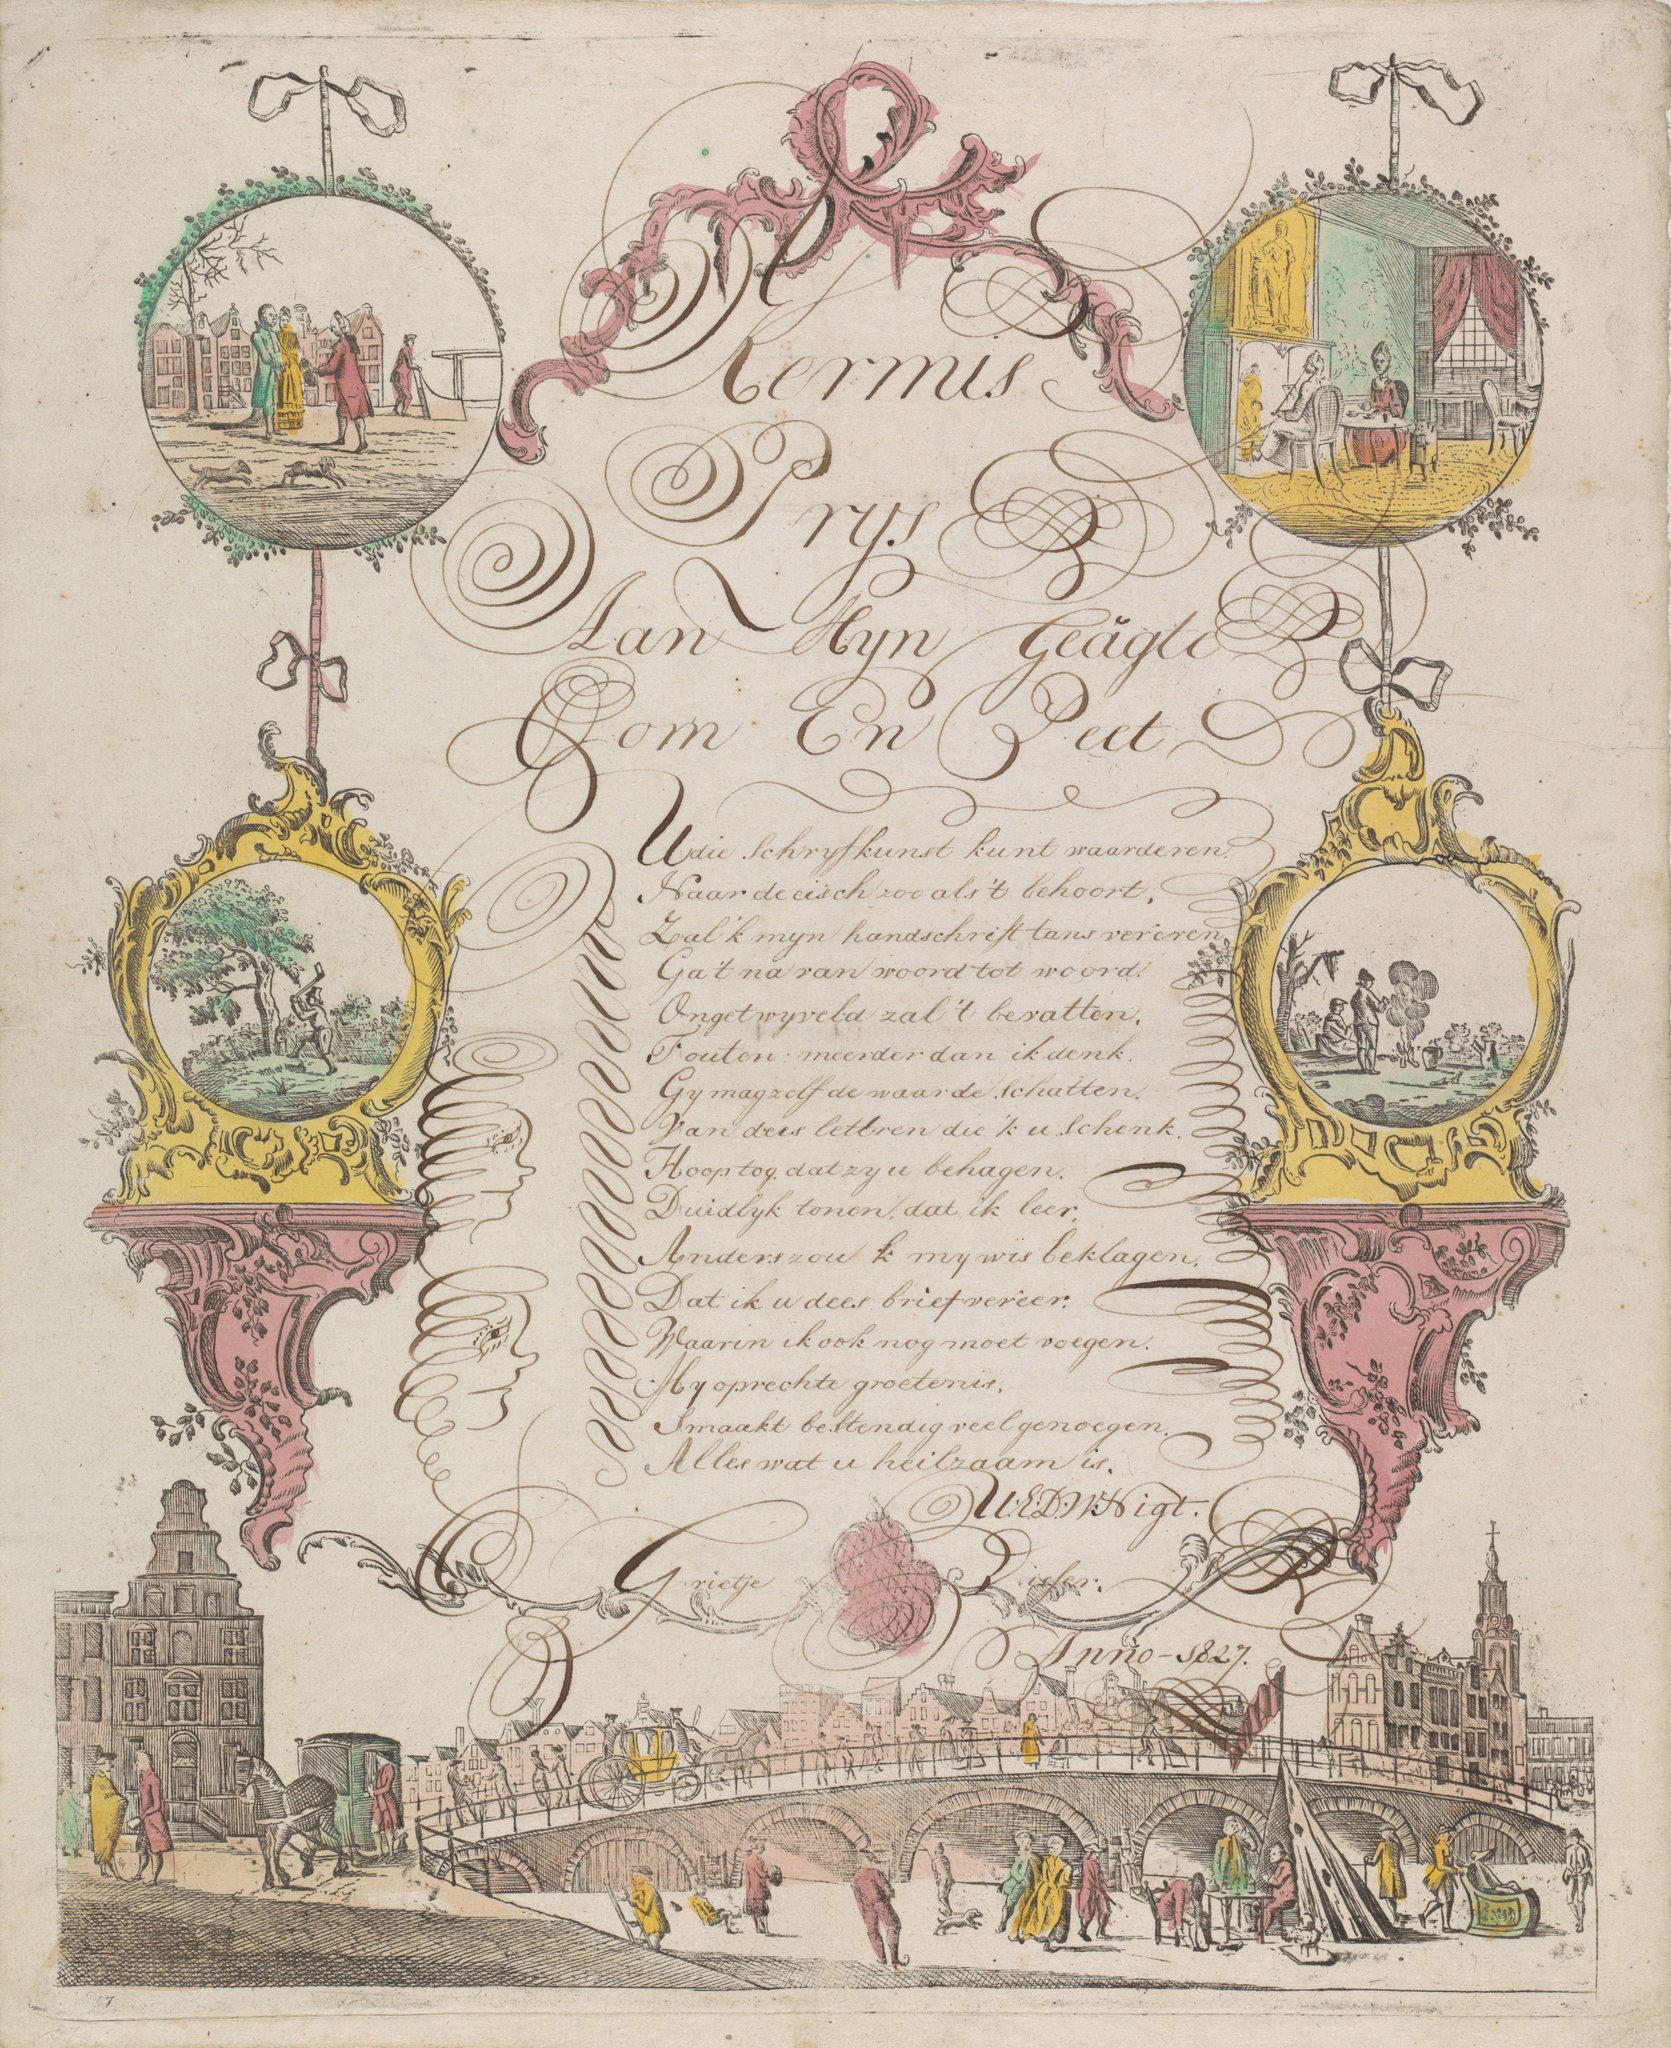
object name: wensbrief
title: Wensbrief met bezigheden en winterse activiteiten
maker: Anonymous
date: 1827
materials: ink, paper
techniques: calligraphy, colour, etching, pen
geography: netherlands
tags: reading, sleigh, sledge (non-sport), skates (winter sports), interior of the house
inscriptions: collector's mark: Lugt 2760, inscription: ‘Kermis / Prys / Aan myn geàgte / Oom en peet / U die schryfkunst kunt waarderen ...’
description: Wensbrief met beschreven cartouche binnen een decoratief kader met voorstellingen van winterse activiteiten, zoals schaatsen en sleeën en andere bezigheden, zoals lezen en houthakken. Handgeschreven bericht in kalligrafie (kermisprijs) van Grietje Visser aan haar oom en peet. Genummerd linksonder: No. 57.